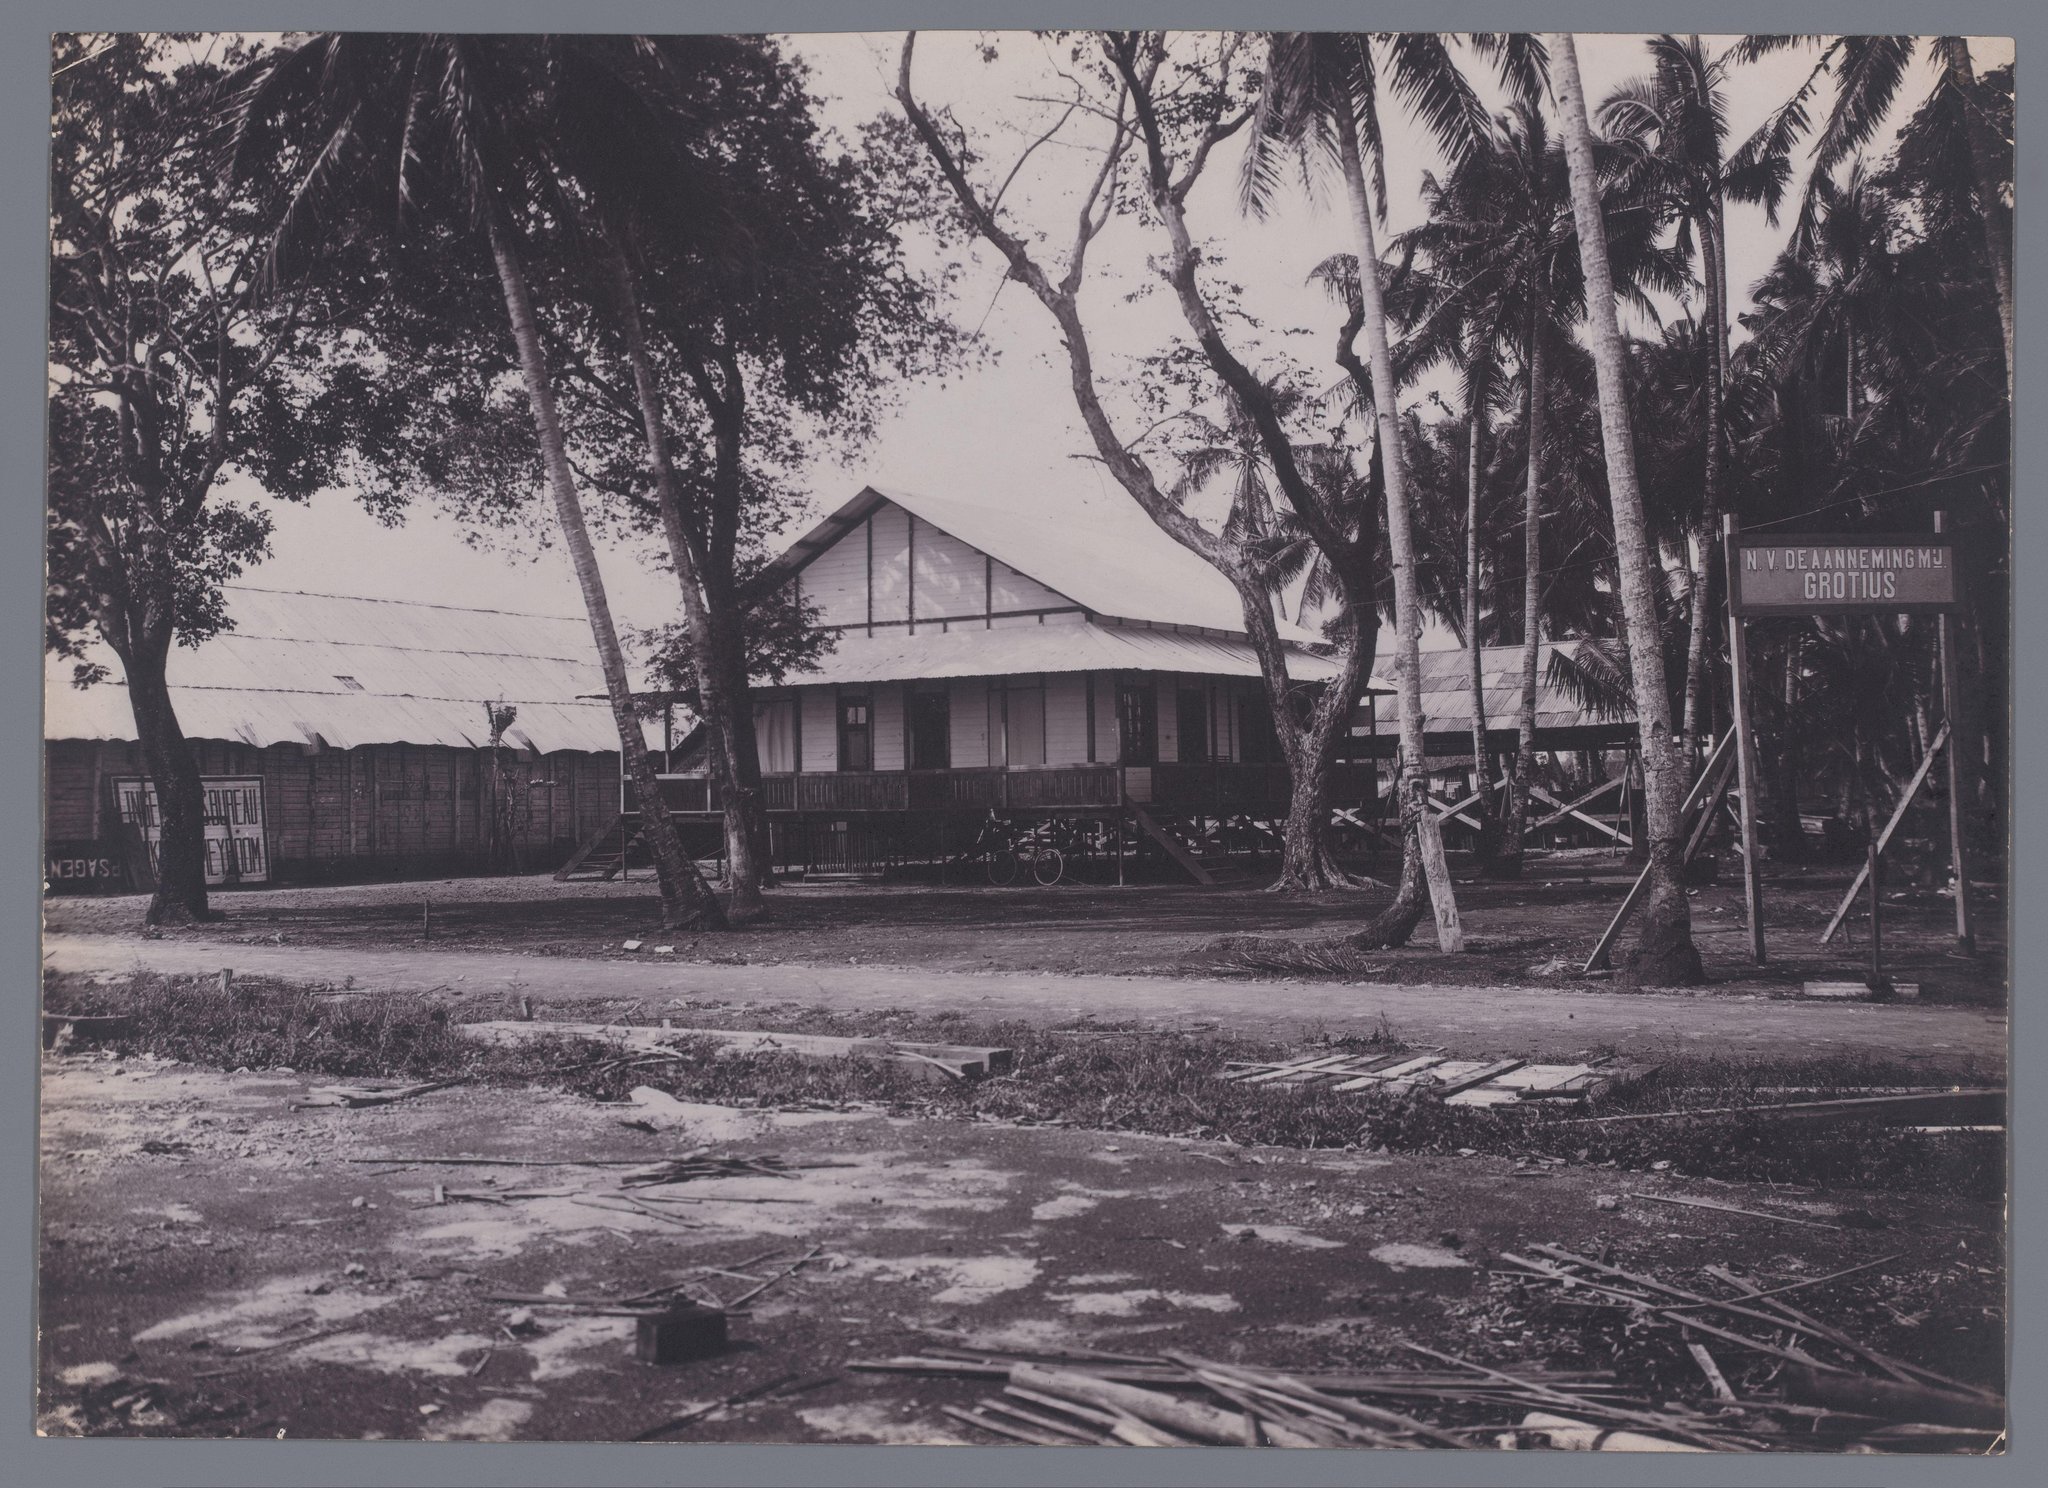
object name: photograph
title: Etablissement van Grotius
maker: Anonymous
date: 1907-1920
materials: photographic support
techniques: gelatin silver print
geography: sumatra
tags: office (~ administration), civic architecture; edifices; dwellings, sumatra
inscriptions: inscription: ‘Etablissement van Grotius, ... / Juli 1920’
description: Pand van de Aanneming Maatschappij 'Grotius', juli 1920. Onderdeel van de groep van losse foto's over de aanleg van de haven Belawan aan de kust voor Medan, Sumatra 1921-1922.